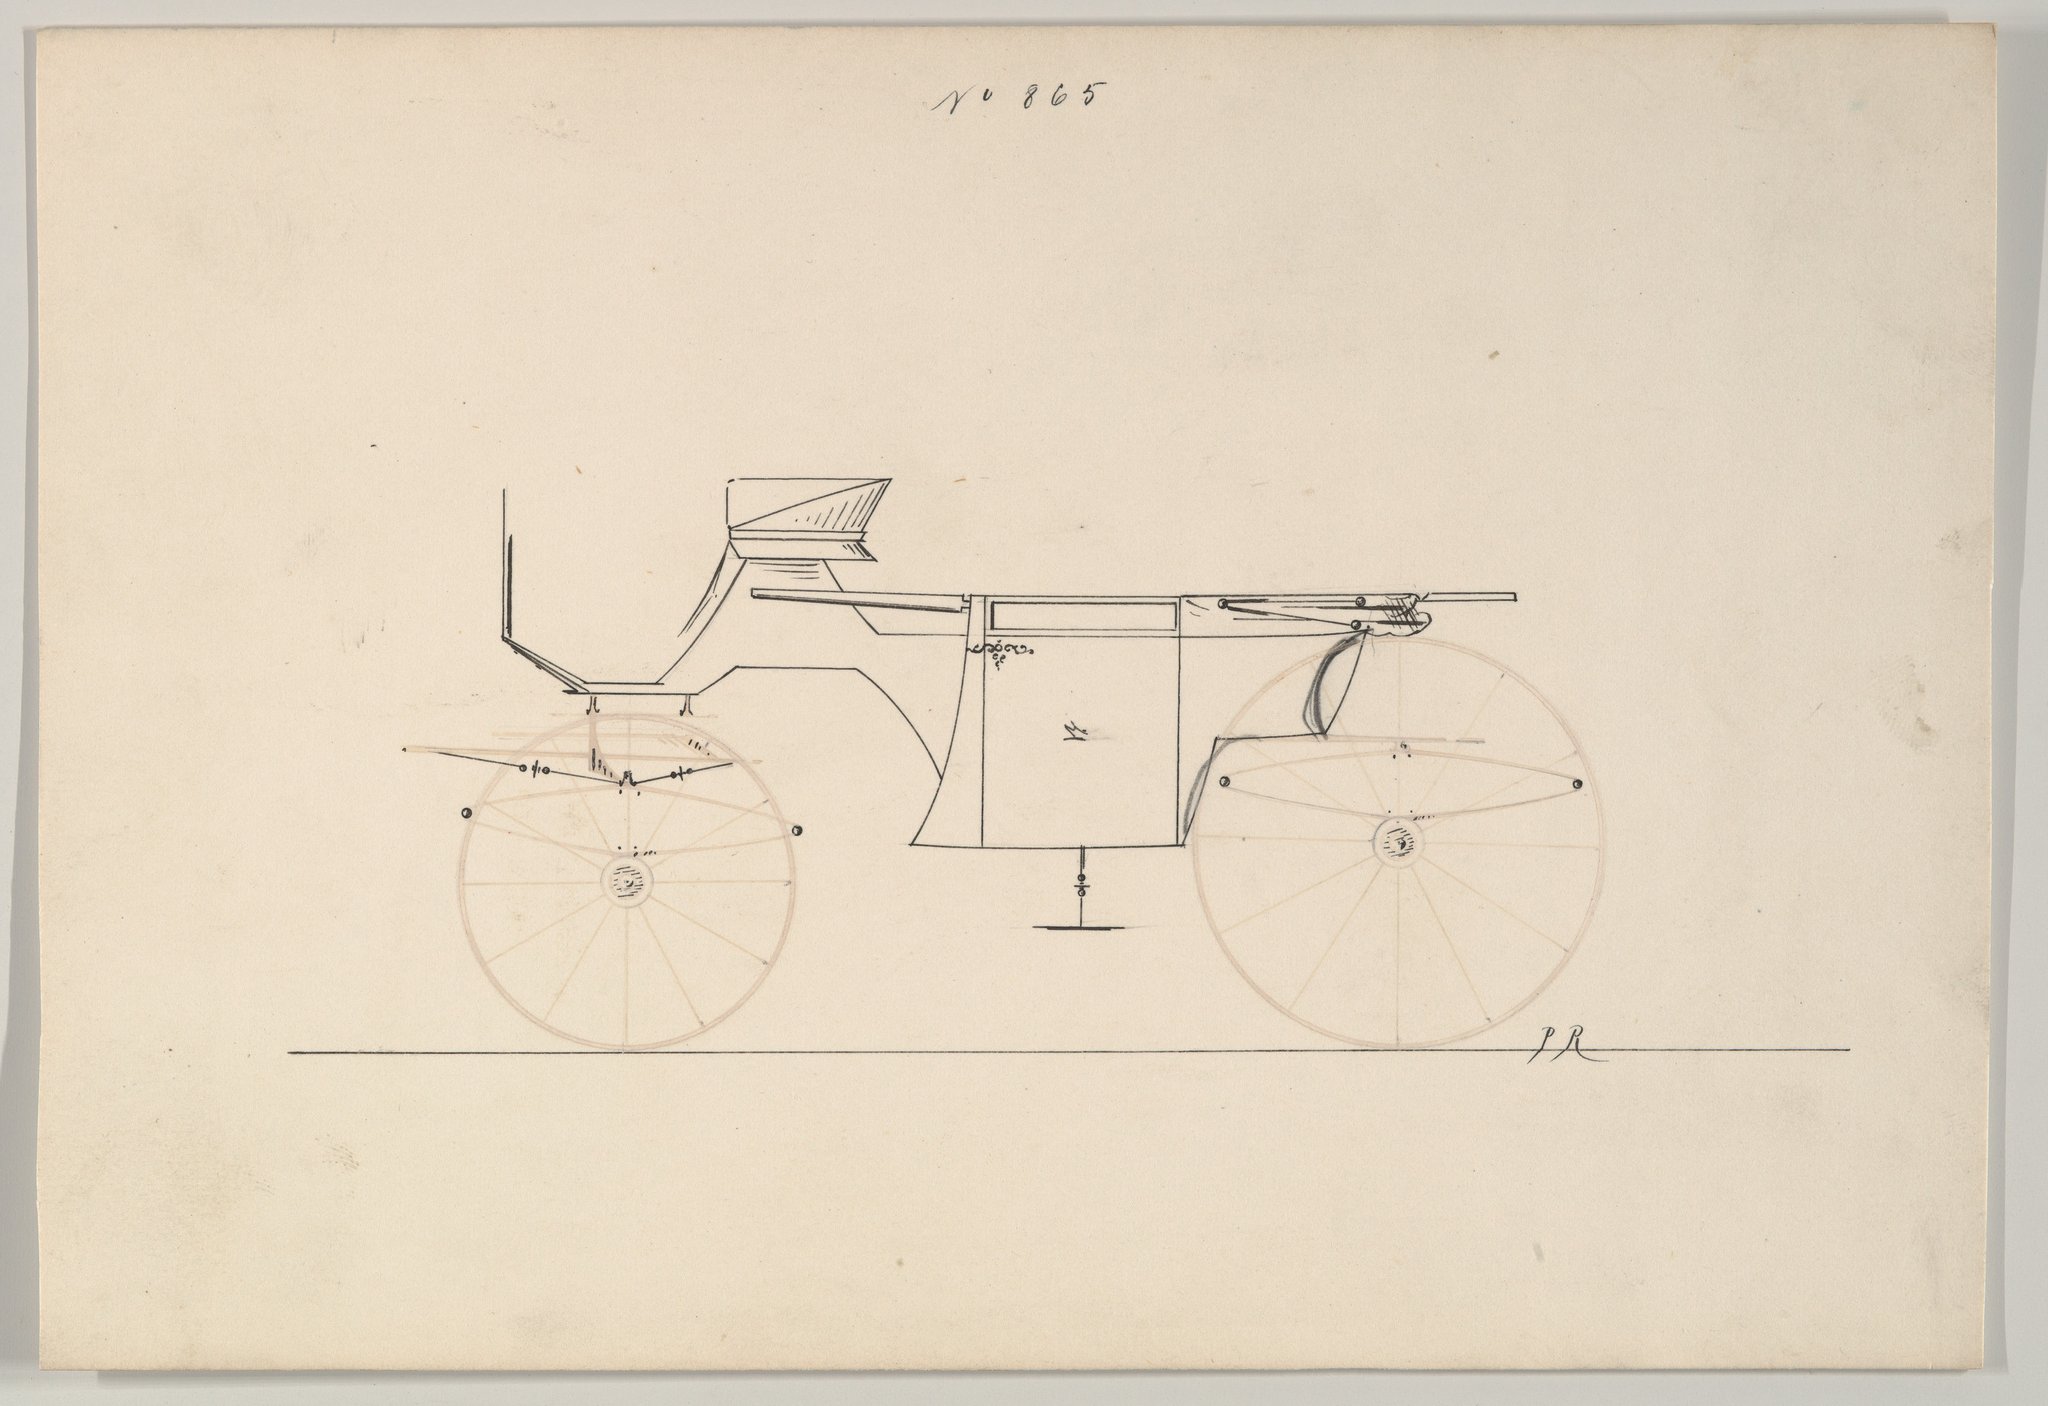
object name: drawing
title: Landaulet #865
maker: brewster & co.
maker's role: manufacturer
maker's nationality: american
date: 1850-1870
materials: graphite, ink, watercolor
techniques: pen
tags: carriages